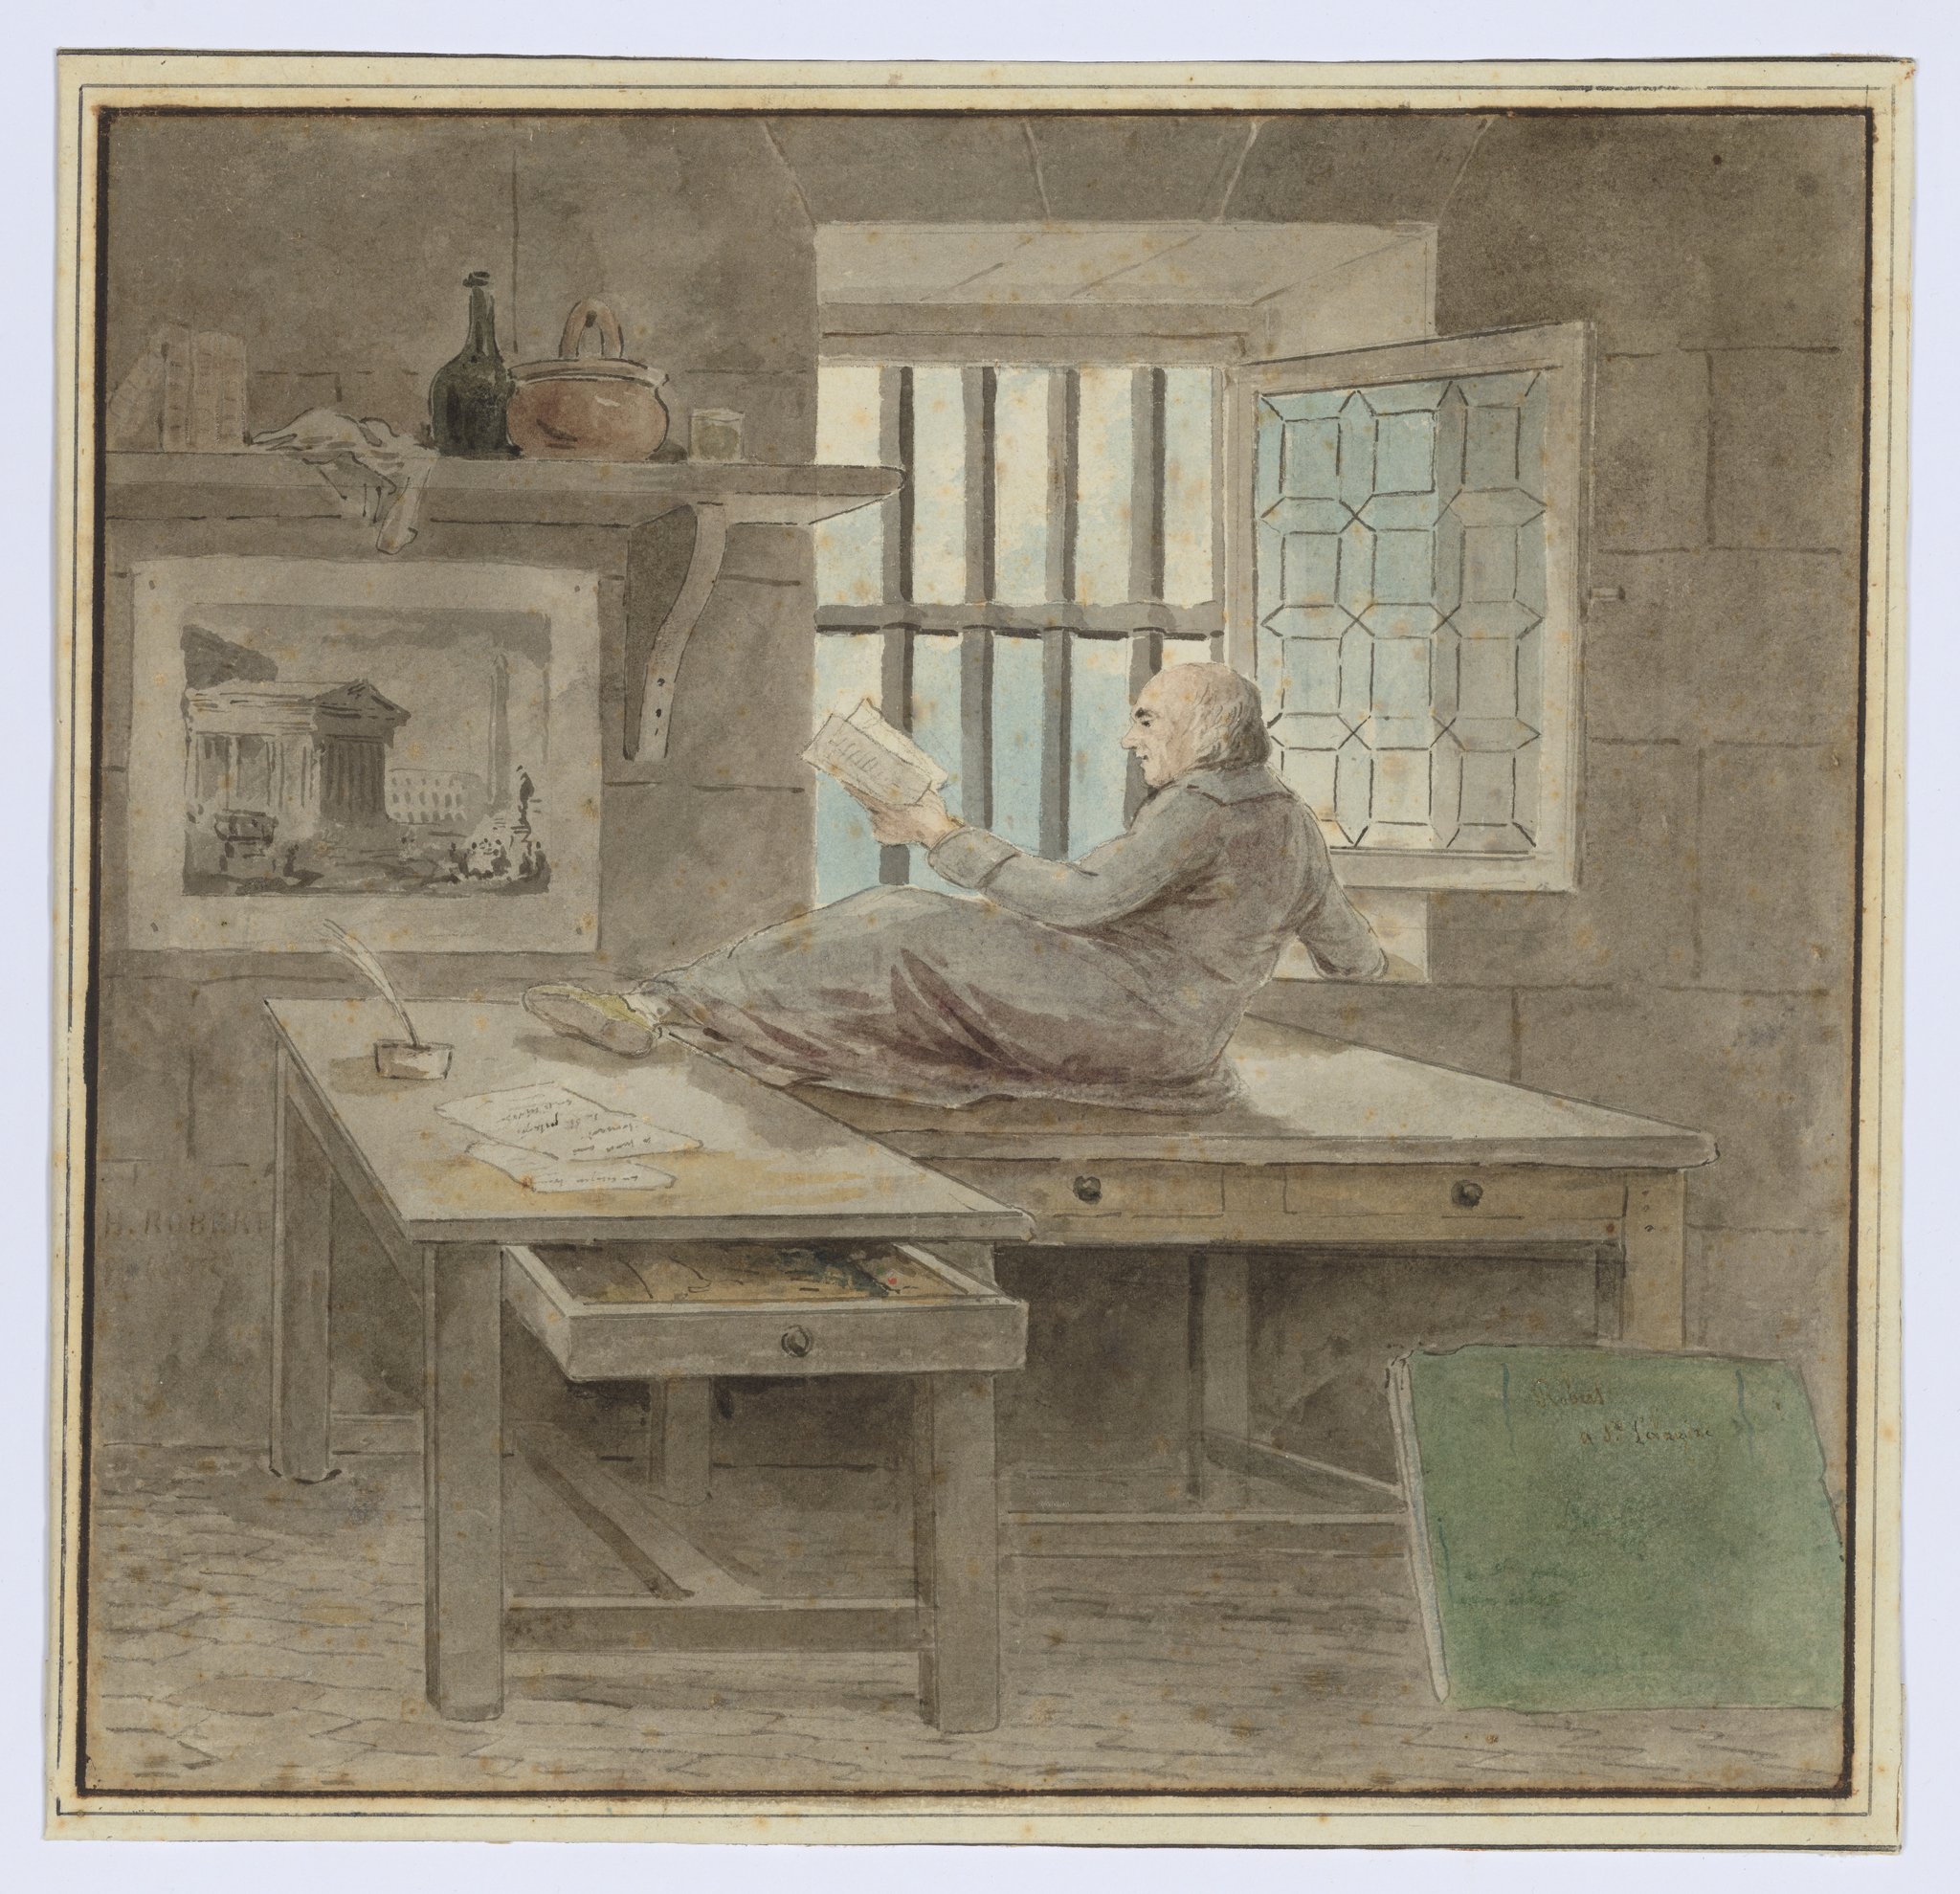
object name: drawing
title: Self-Portrait in Saint-Lazare Prison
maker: hubert robert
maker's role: artist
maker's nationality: french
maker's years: 1733-1808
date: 1793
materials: ink, watercolor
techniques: brush, pen, wash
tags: prisons,interiors,self-portraits,reading,tables